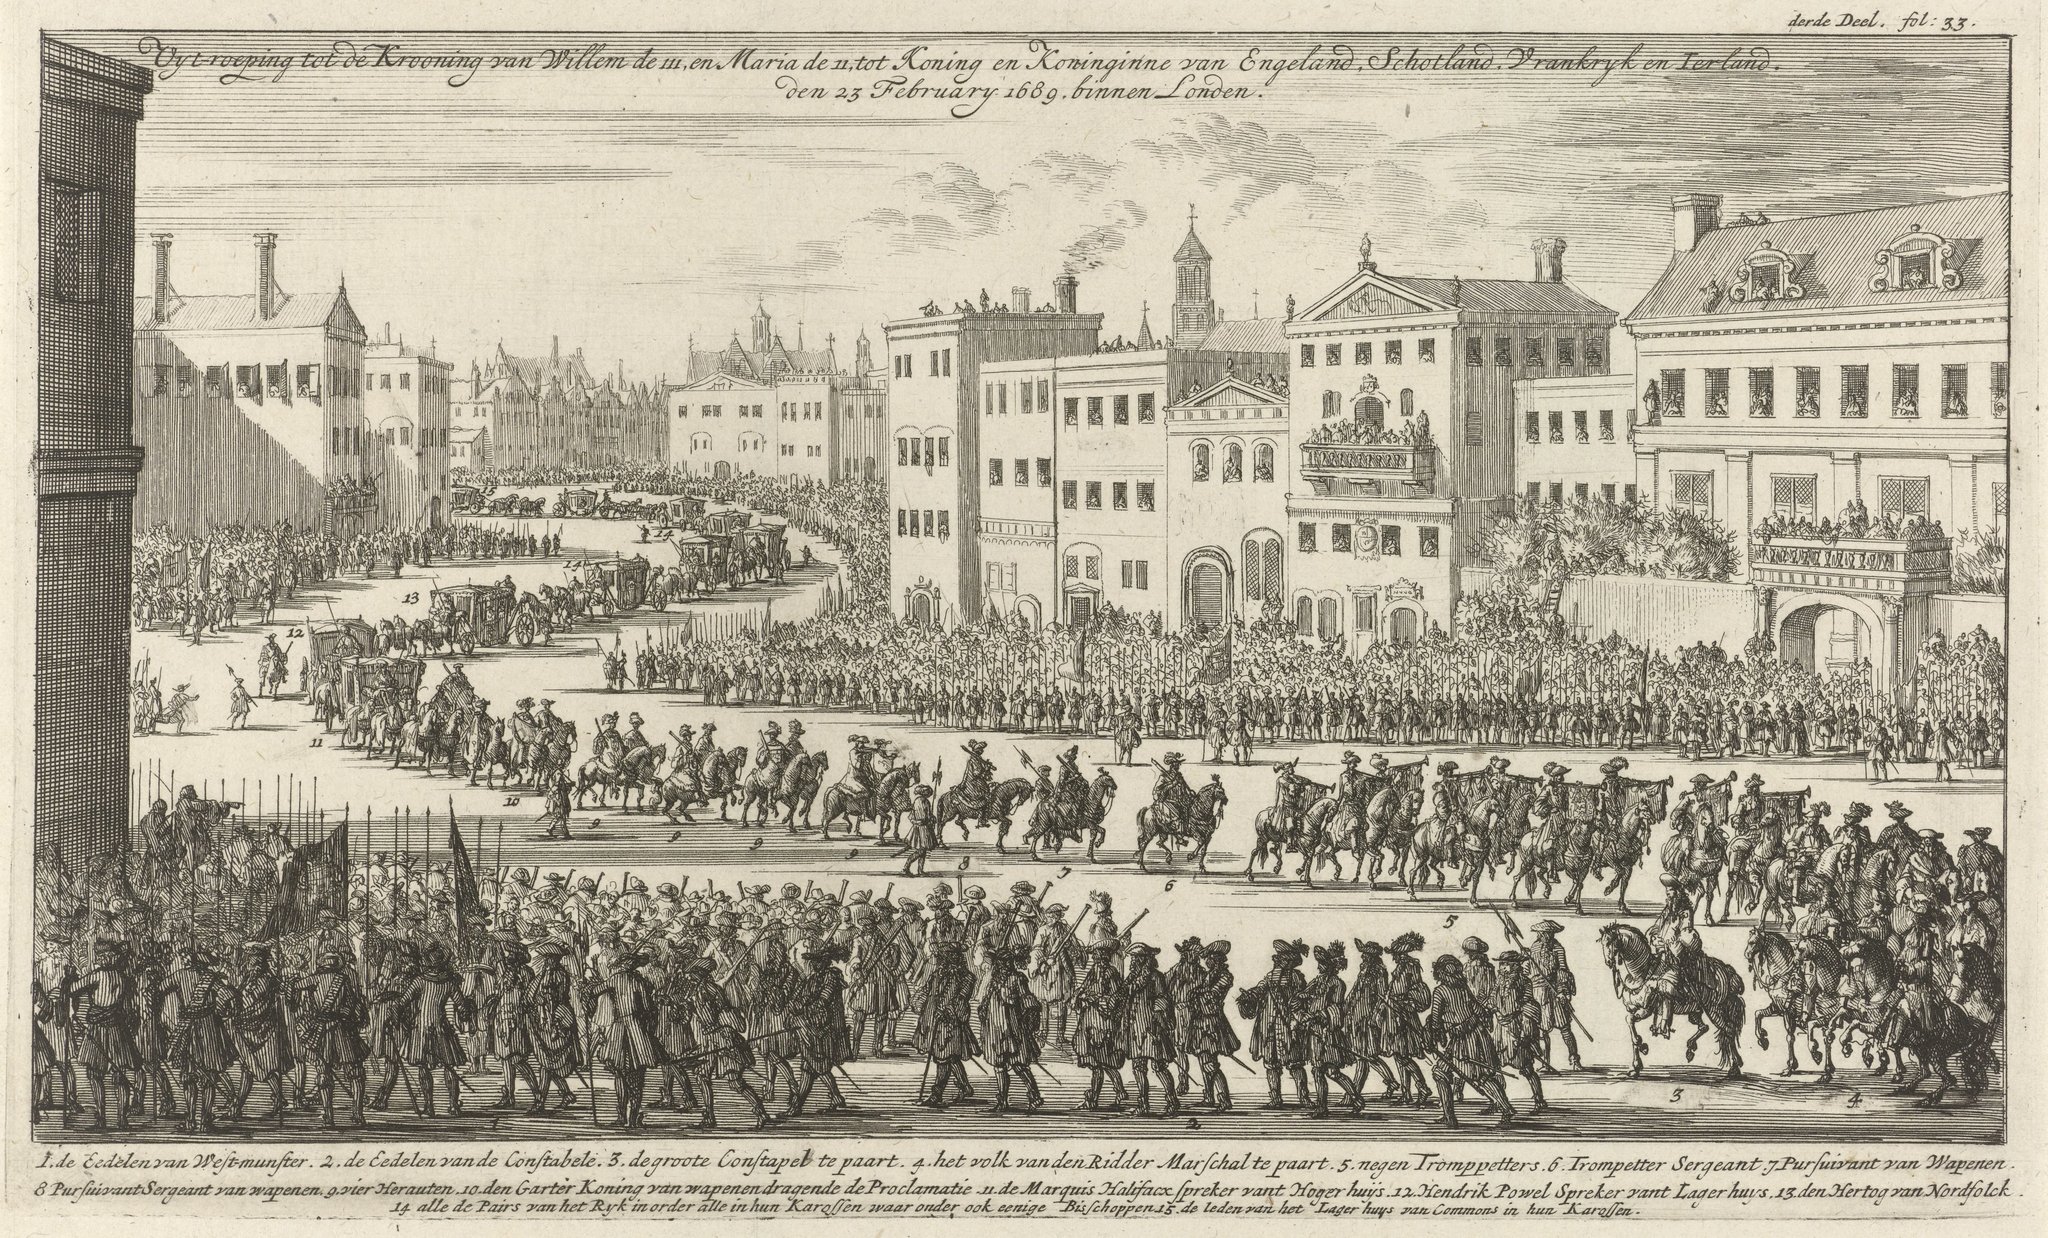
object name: print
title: Uyt roeping tot de Krooning van Willem de III, en Maria de II, tot Koning en Koninginne van Engeland, Schotland, Vrankryk en Ierland. den 23 February 1689, binnen Londen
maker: jan luyken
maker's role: draughtsman, print maker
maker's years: 1649-1712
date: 1689-1691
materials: paper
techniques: etching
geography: amsterdam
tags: the hague, william iii (prince of orange and king of england, scotland, and ireland), london, maria ii stuart (koningin van engeland, schotland en ierland), ceremonial procession, parade, pageant ~ installation of a ruler, lower house, parliament, chamber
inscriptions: collector's mark: Lugt 2228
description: Een lange stoet met de leden van het Parlement door de straten van Londen om een uitroep te doen tot kroning van de prins en prinses van Oranje tot koning en koningin van Engeland, 23 februari 1689. In het onderschrift de legenda 1-15. Prent rechtsboven gemerkt: derde Deel: fol: 33.